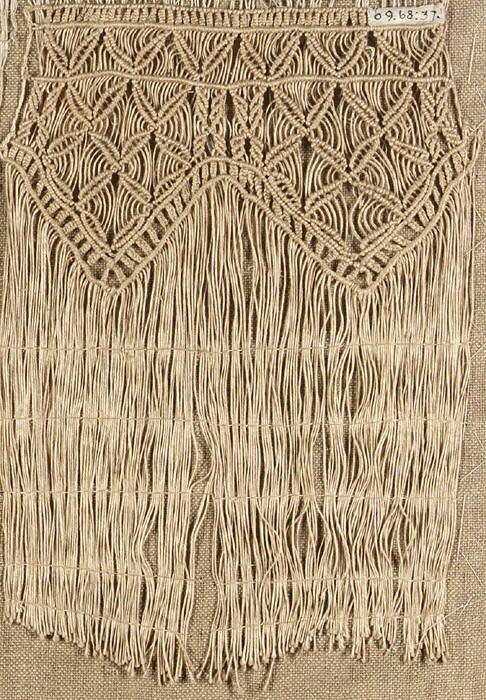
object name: piece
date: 1867-1900